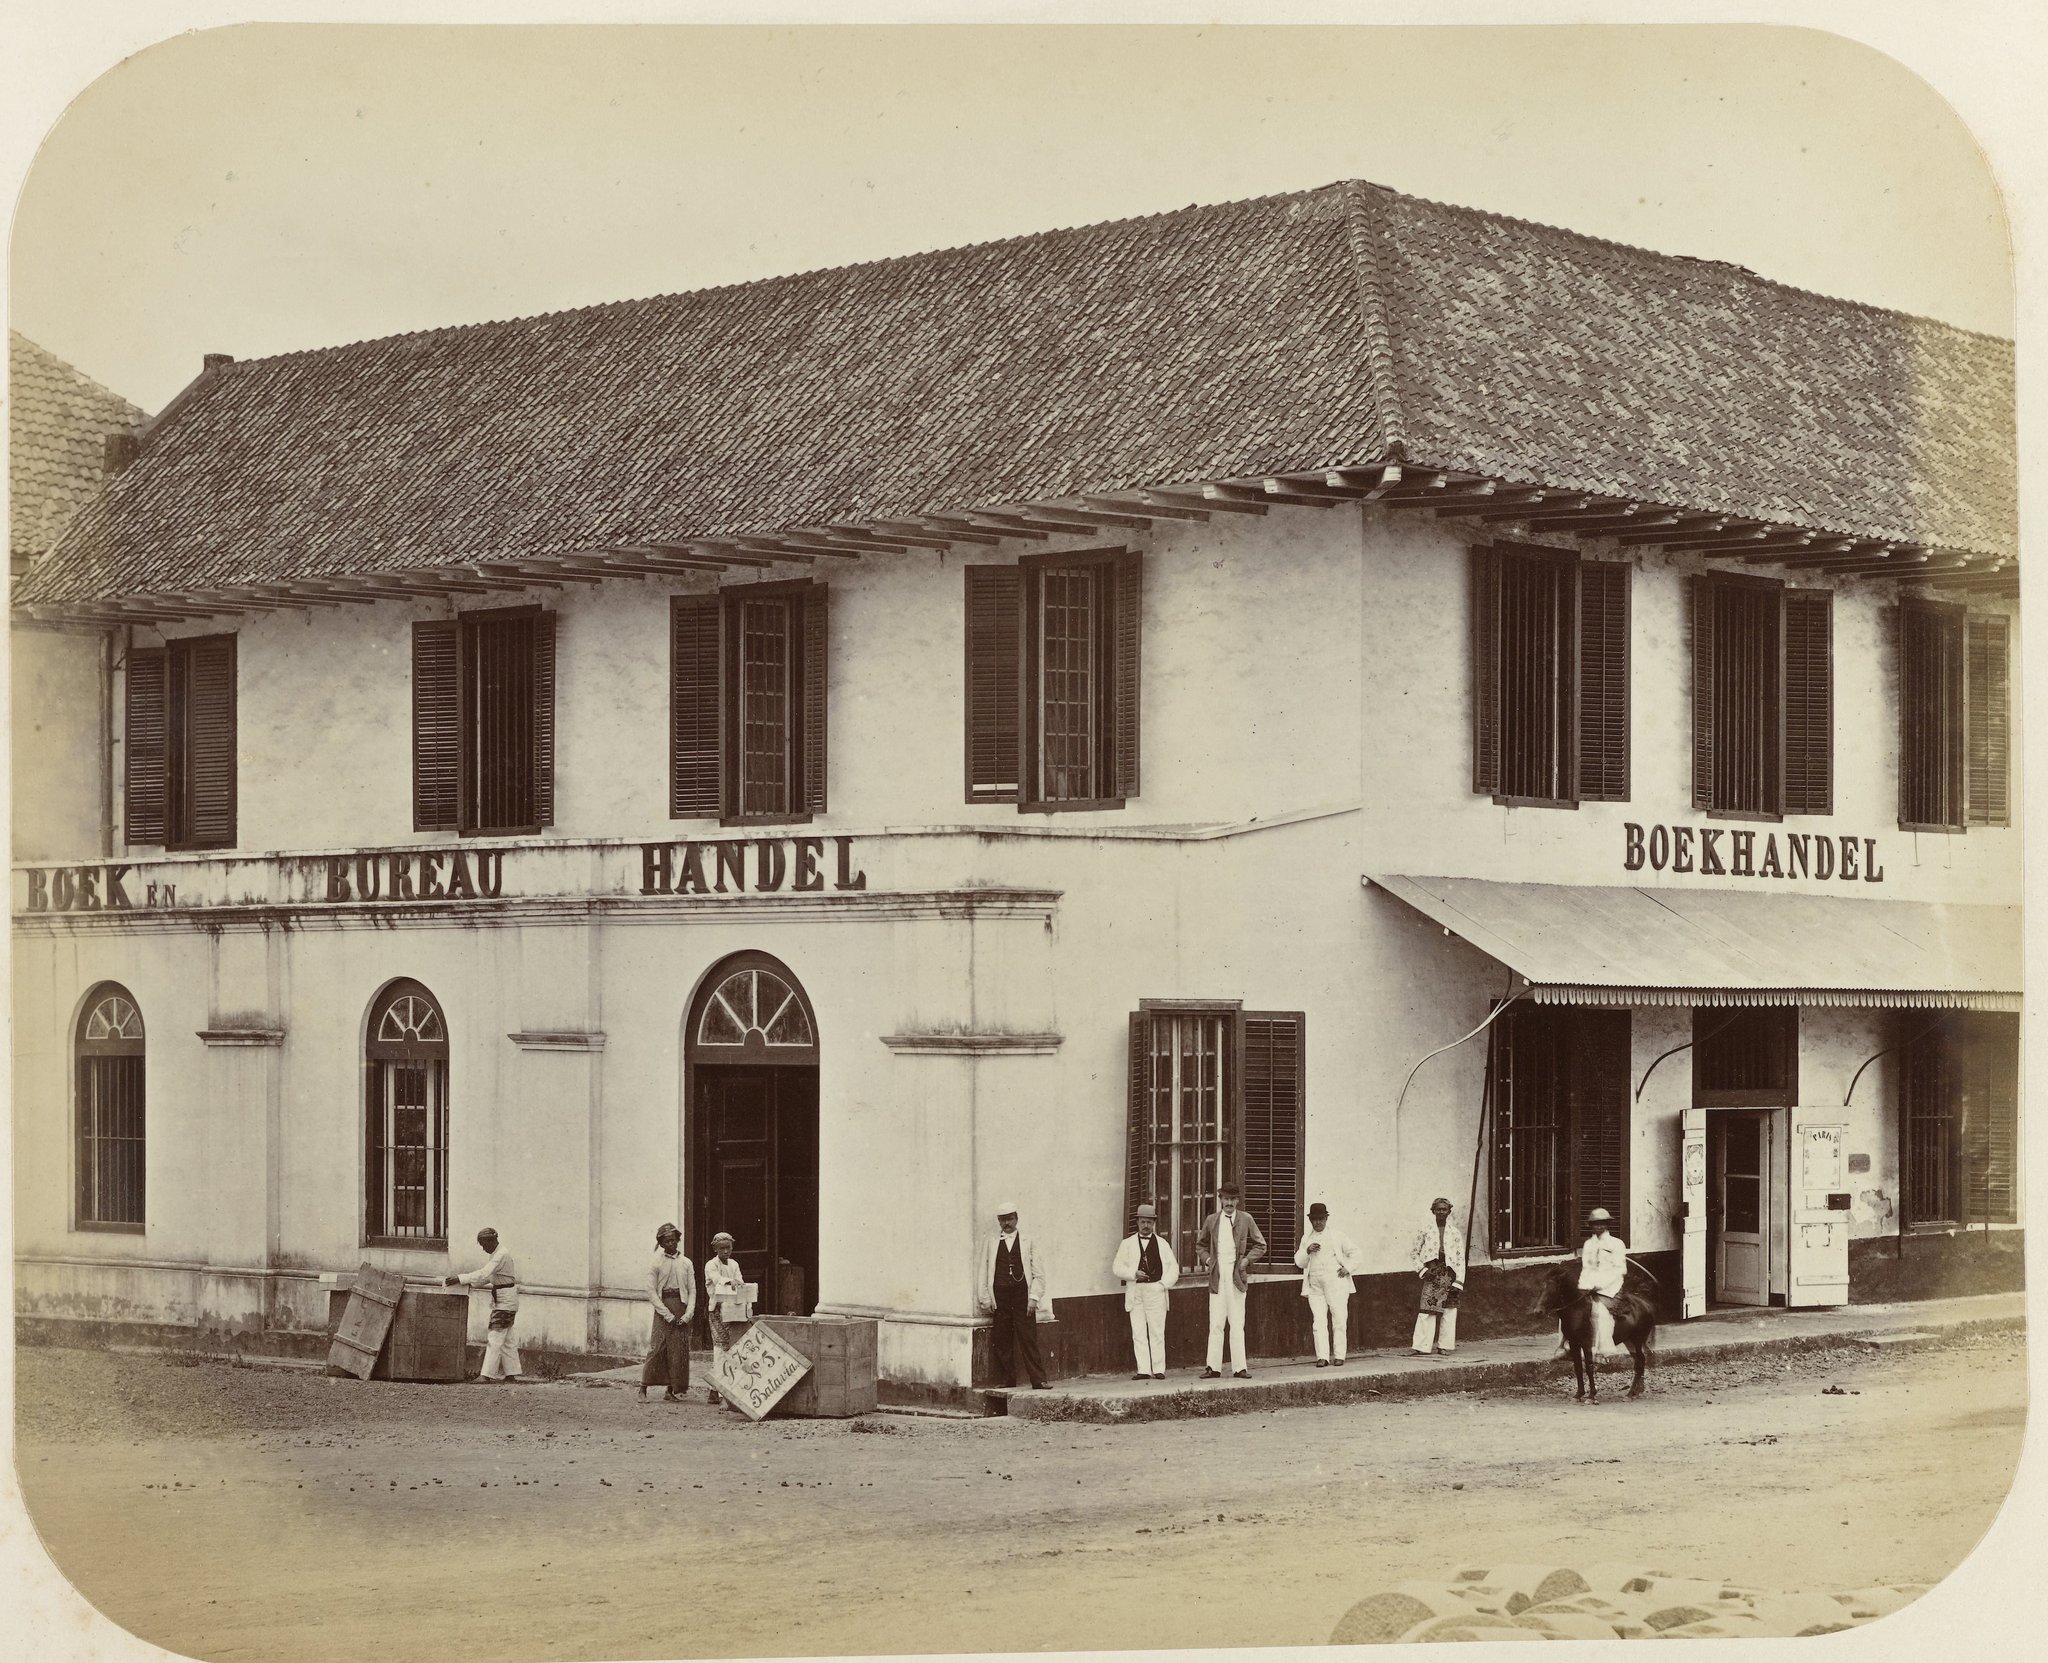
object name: photograph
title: Boekhandel Kolff & Co. te Batavia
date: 1865-1872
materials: photographic support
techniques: albumen print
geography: batavia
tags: shop, store, public road, book-shop, bookseller, java, batavia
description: Gezicht op de boekhandel Kolff & Co aan de kruising van de Kali Besar en Pasar Pinang te Batavia. Voor het gebouw poseren enkele Nederlanders en Indiërs. Ingeplakte foto in het fotoalbum getiteld: Gezichten van Java.